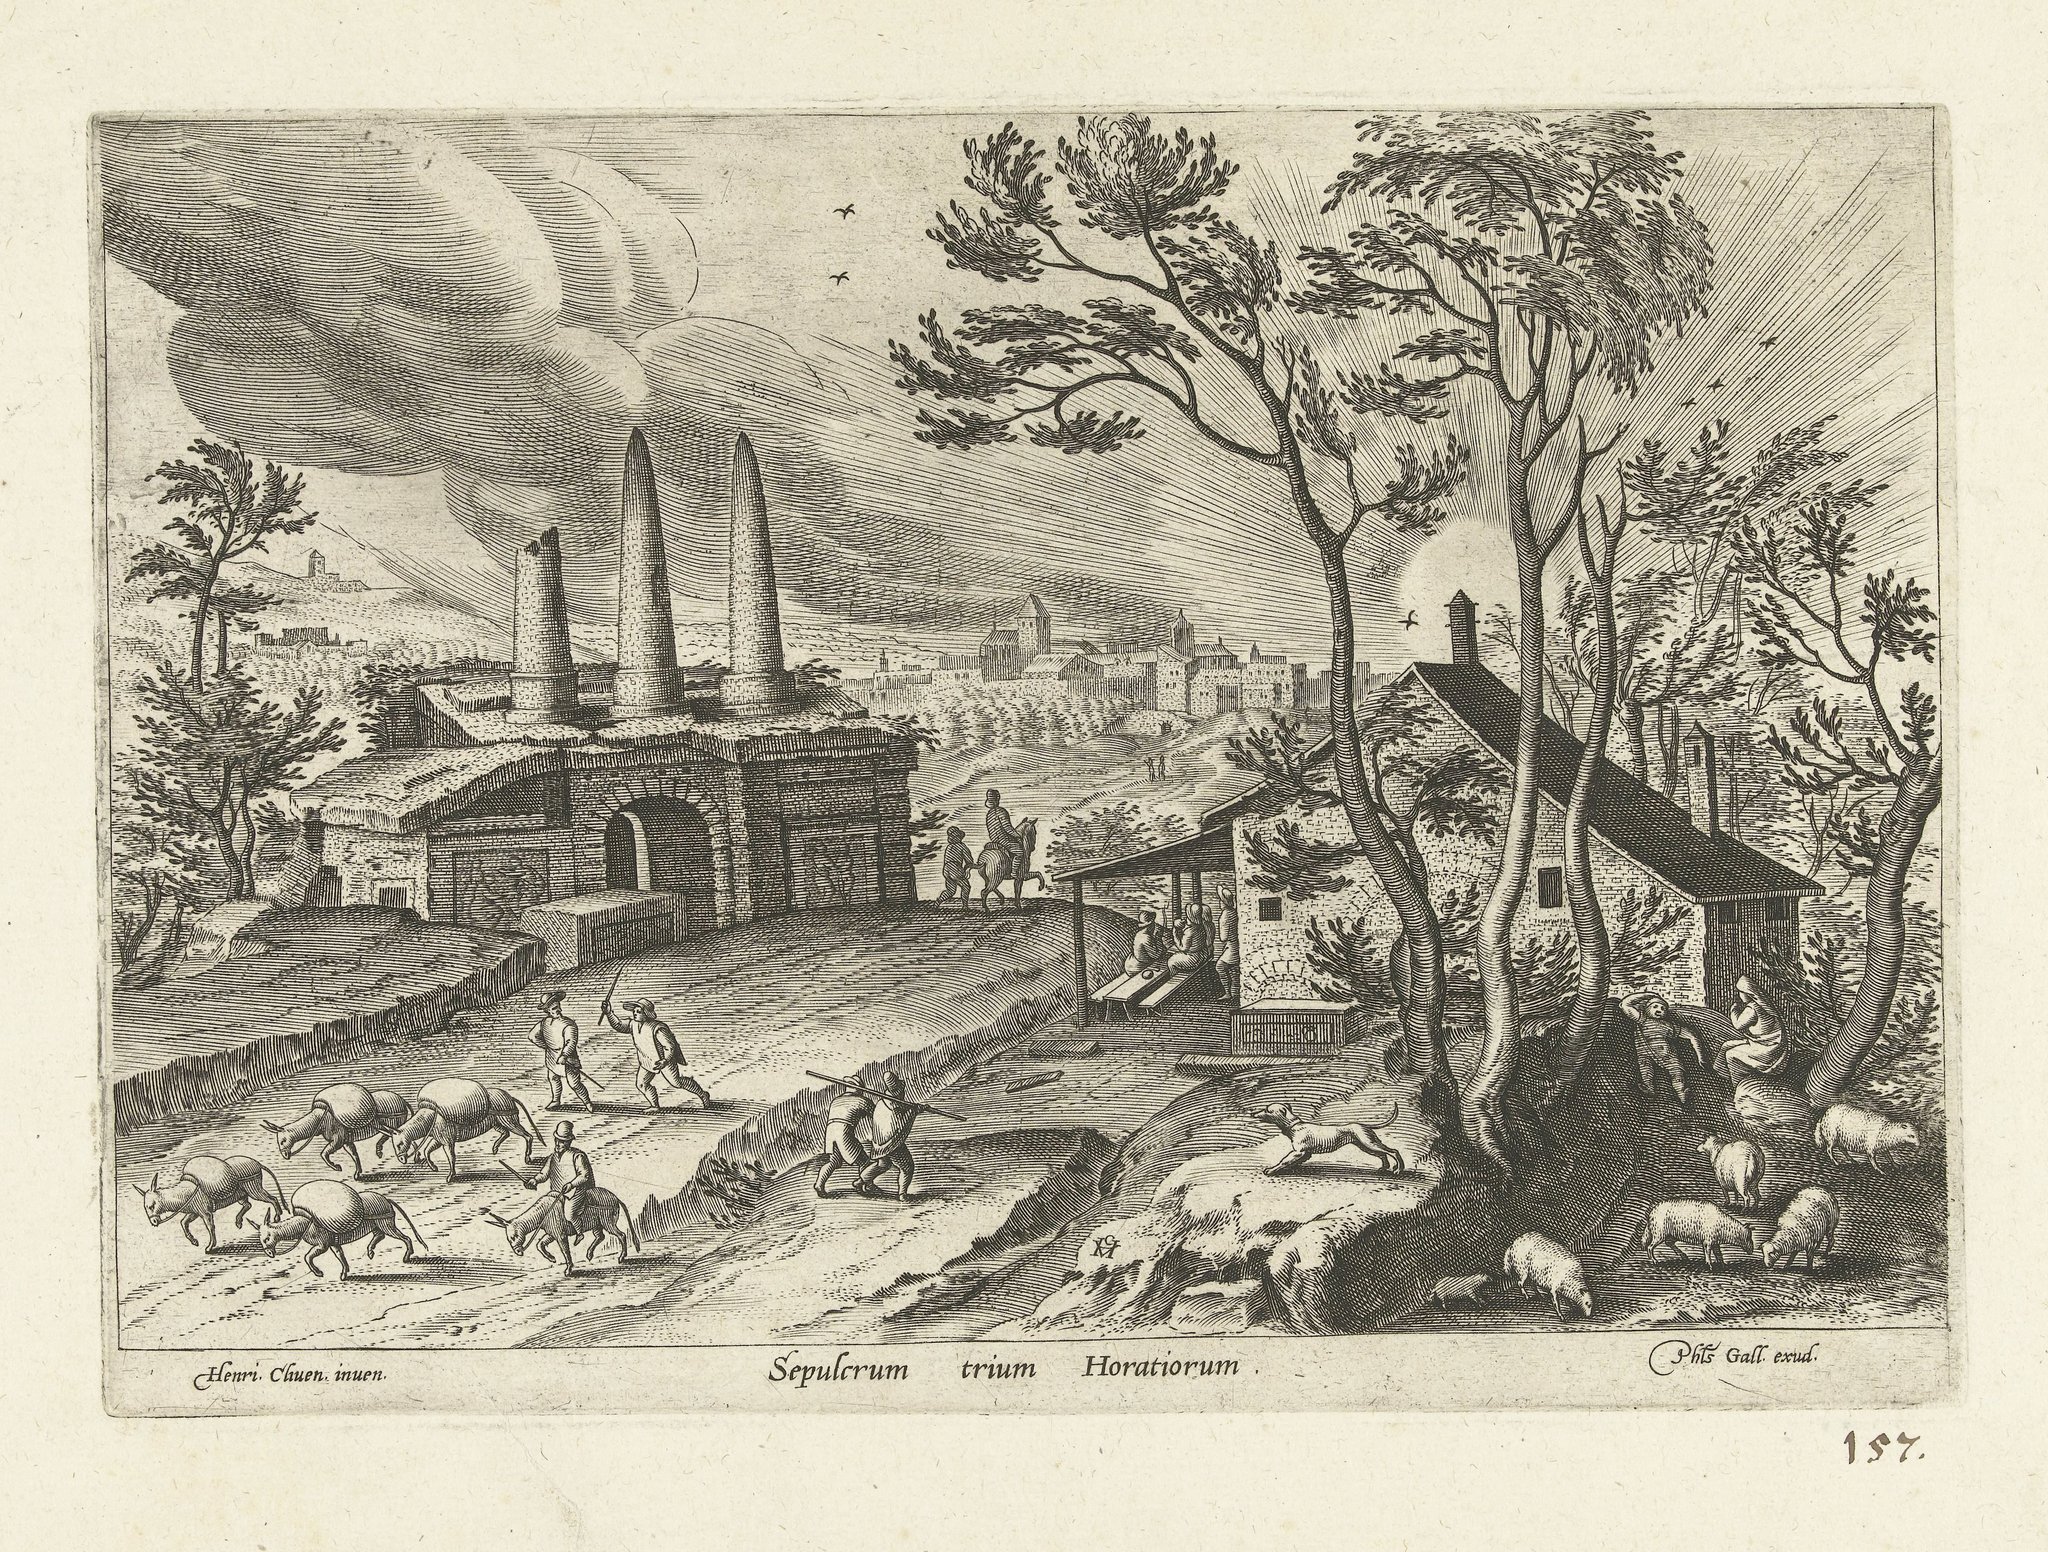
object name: print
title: Ruinarum varii prospectus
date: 1585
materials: paper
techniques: engraving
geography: antwerp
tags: ruin of a building ~ architecture, landscape with other man-made constructions not mentioned above, e.g.: graveyards, playgrounds, etc., (story of) the horatii, three brothers from rome, catacombs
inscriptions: collector's mark: Lugt 2228, number: ‘157’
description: Italiaans landschap met waarschijnlijk de ruïne van de begraafplaats van de legendarische broers Horatii. In het midden van de prent een weg met een karavaan. Rechts een herder met schapen. De prent is deel van een serie die verschillende plaatsen in het Middellandse Zeegebied afbeeldt.